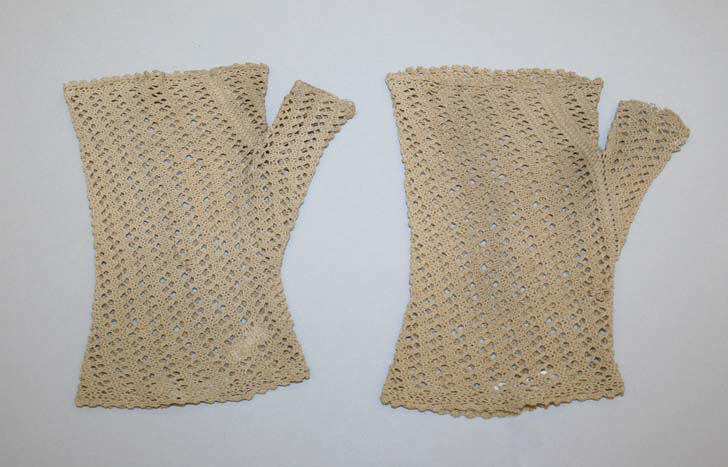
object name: mitt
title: Mitts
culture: american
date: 1850-1869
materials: cotton